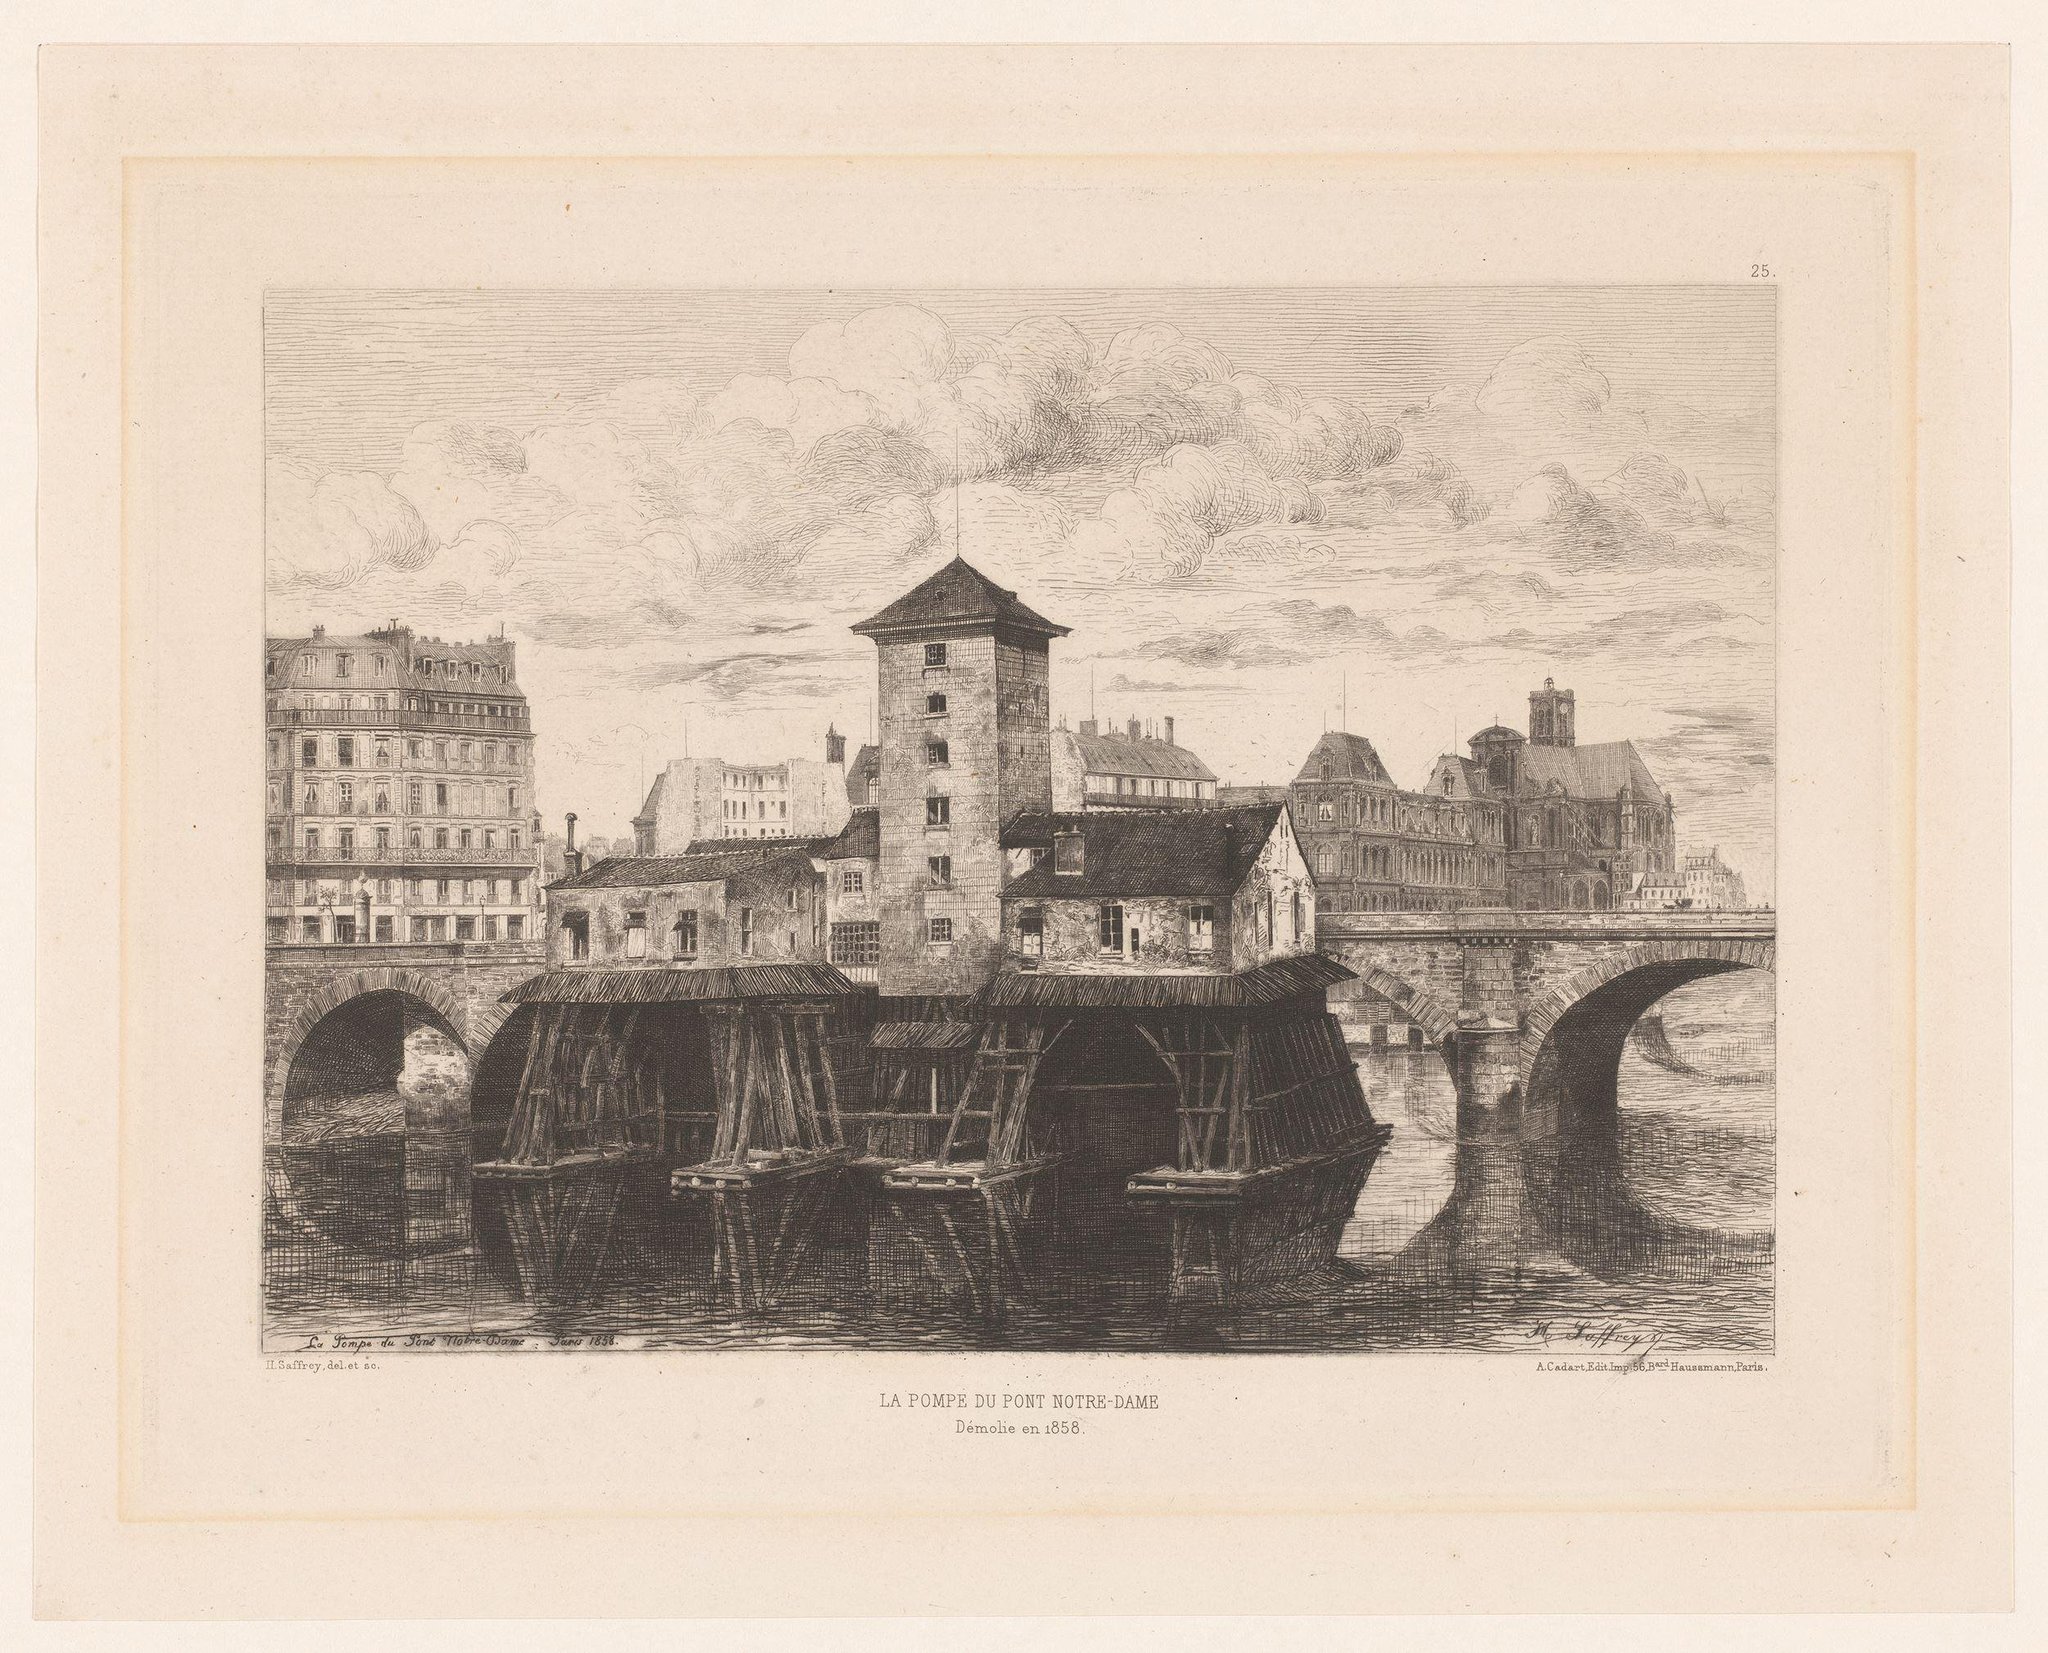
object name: print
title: La Pompe du Pont Notre Dame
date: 1858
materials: paper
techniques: drypoint, etching, intaglio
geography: paris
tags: bridge in city across river, canal, etc.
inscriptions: collector's mark: Lugt 2228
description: Prent uit: L'Eau Forte en 1875. Parijs: Alfred Cadard, 1875. Plaat 25.